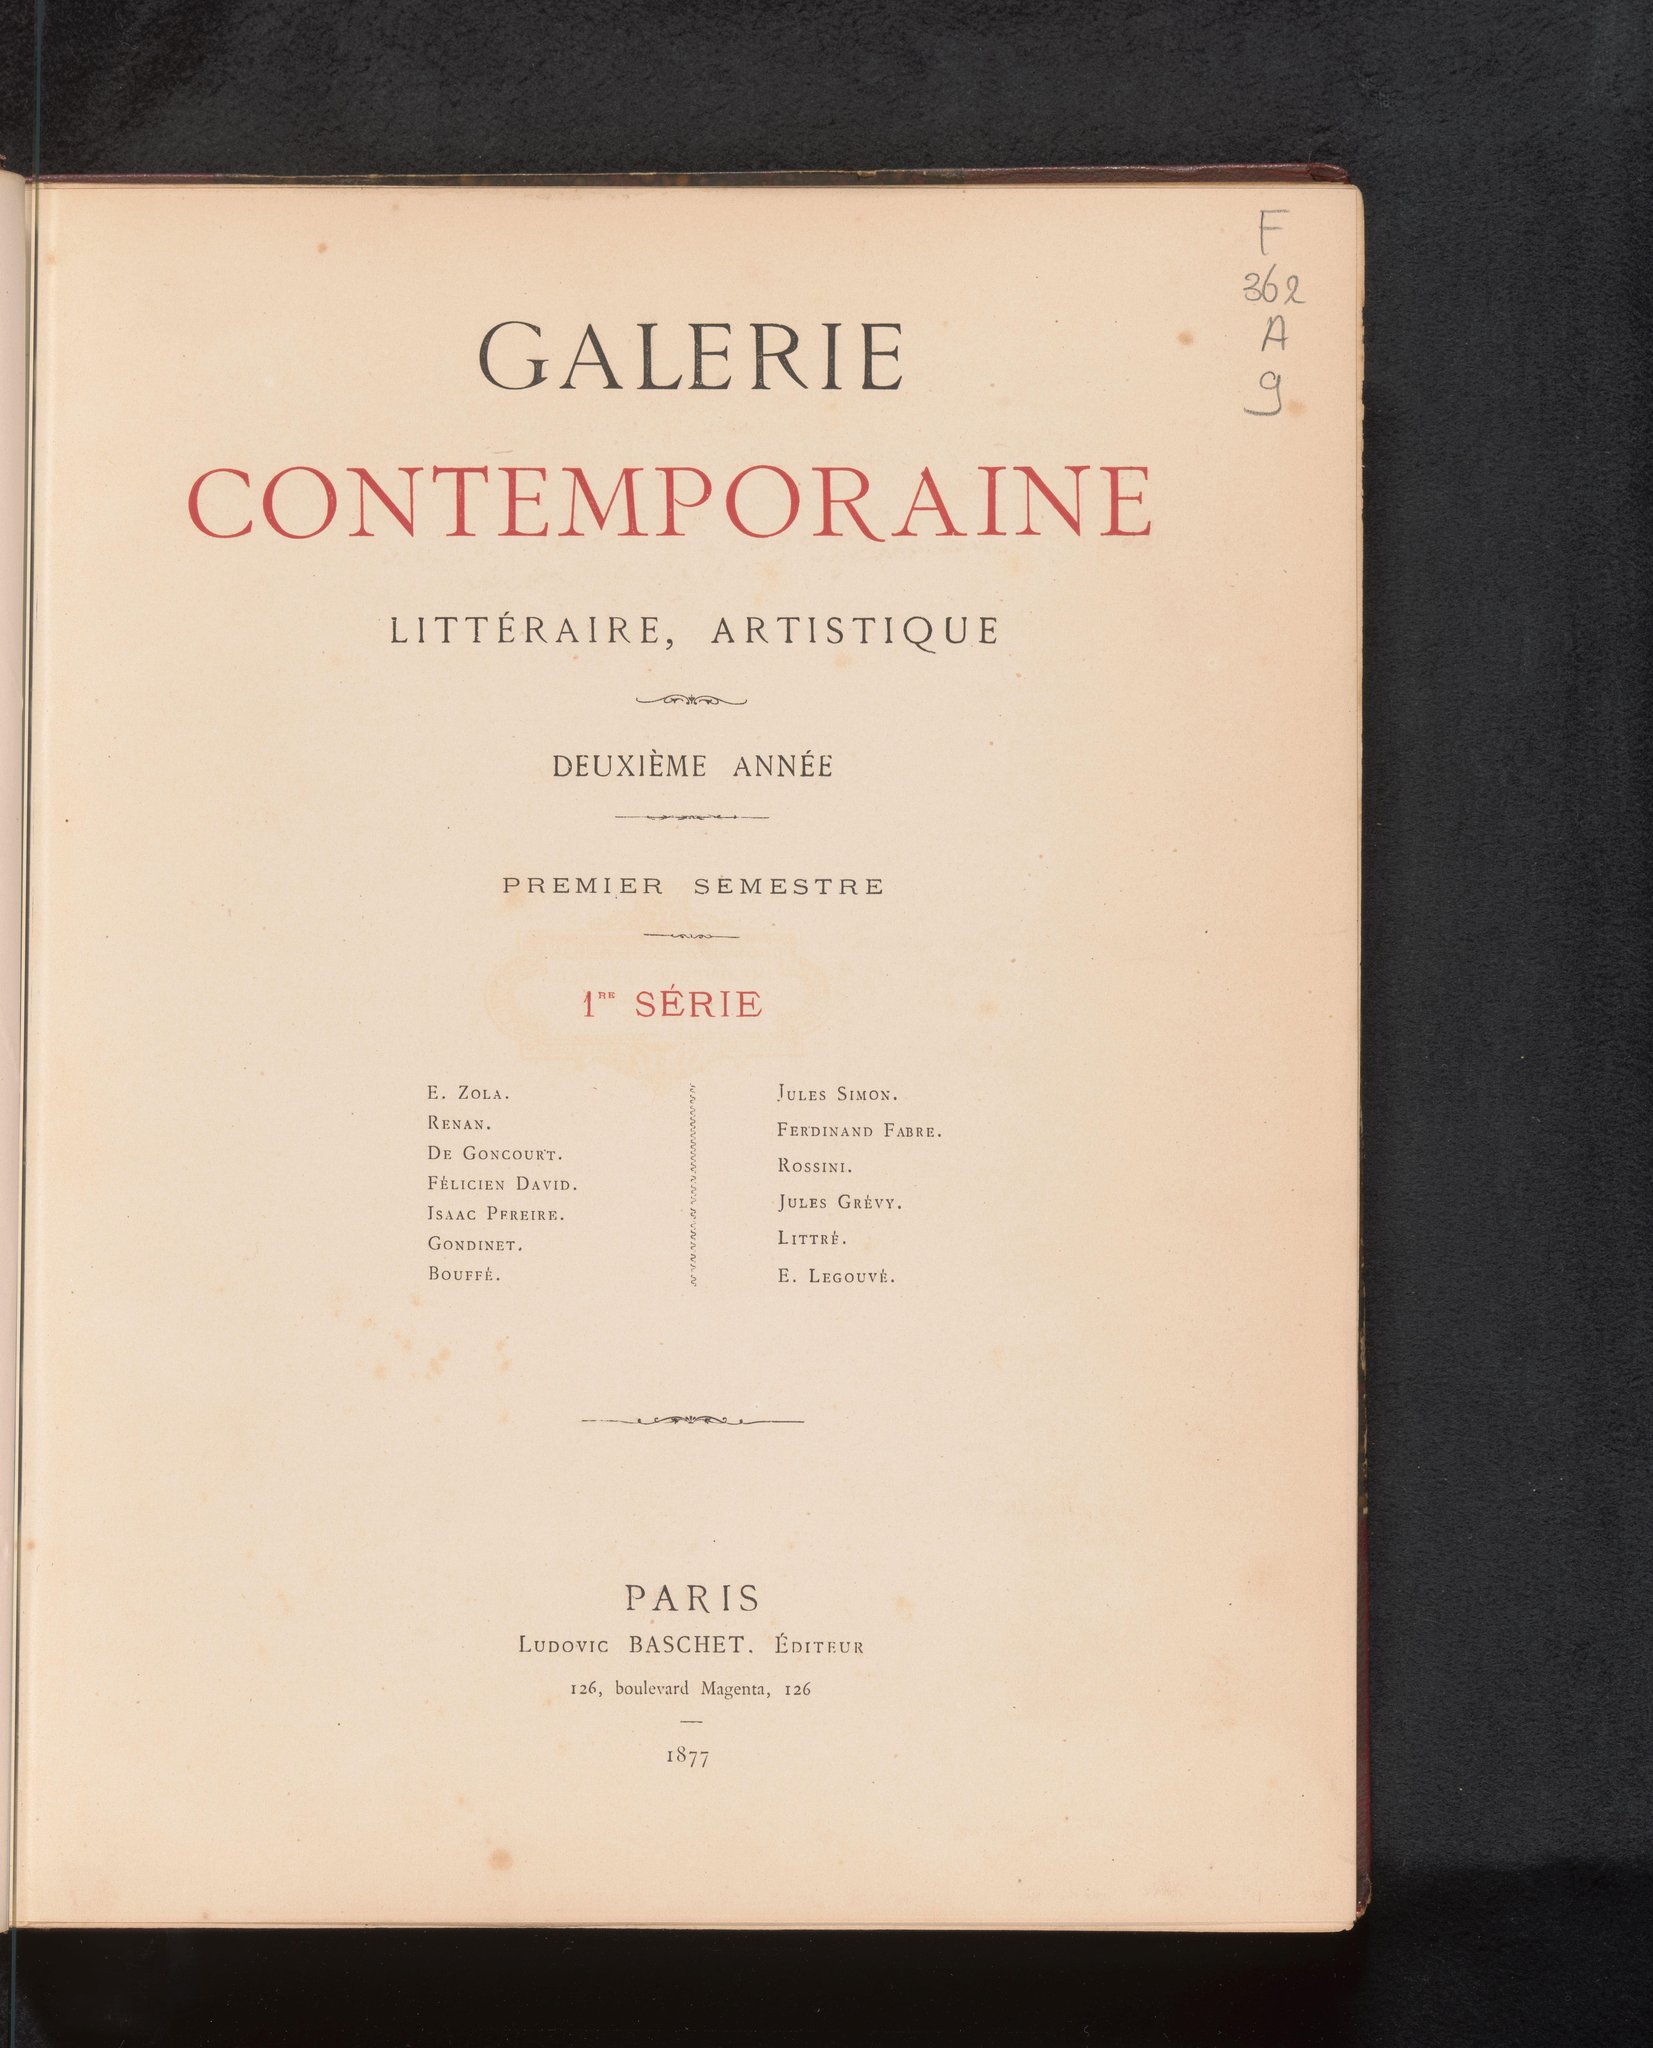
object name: book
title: Galerie contemporaine : litteraire, artistique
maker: ludovic baschet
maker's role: publisher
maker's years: 1834-1909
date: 1877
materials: paper, photographic support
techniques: marbled paper, printing, printing block, woodburytype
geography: paris